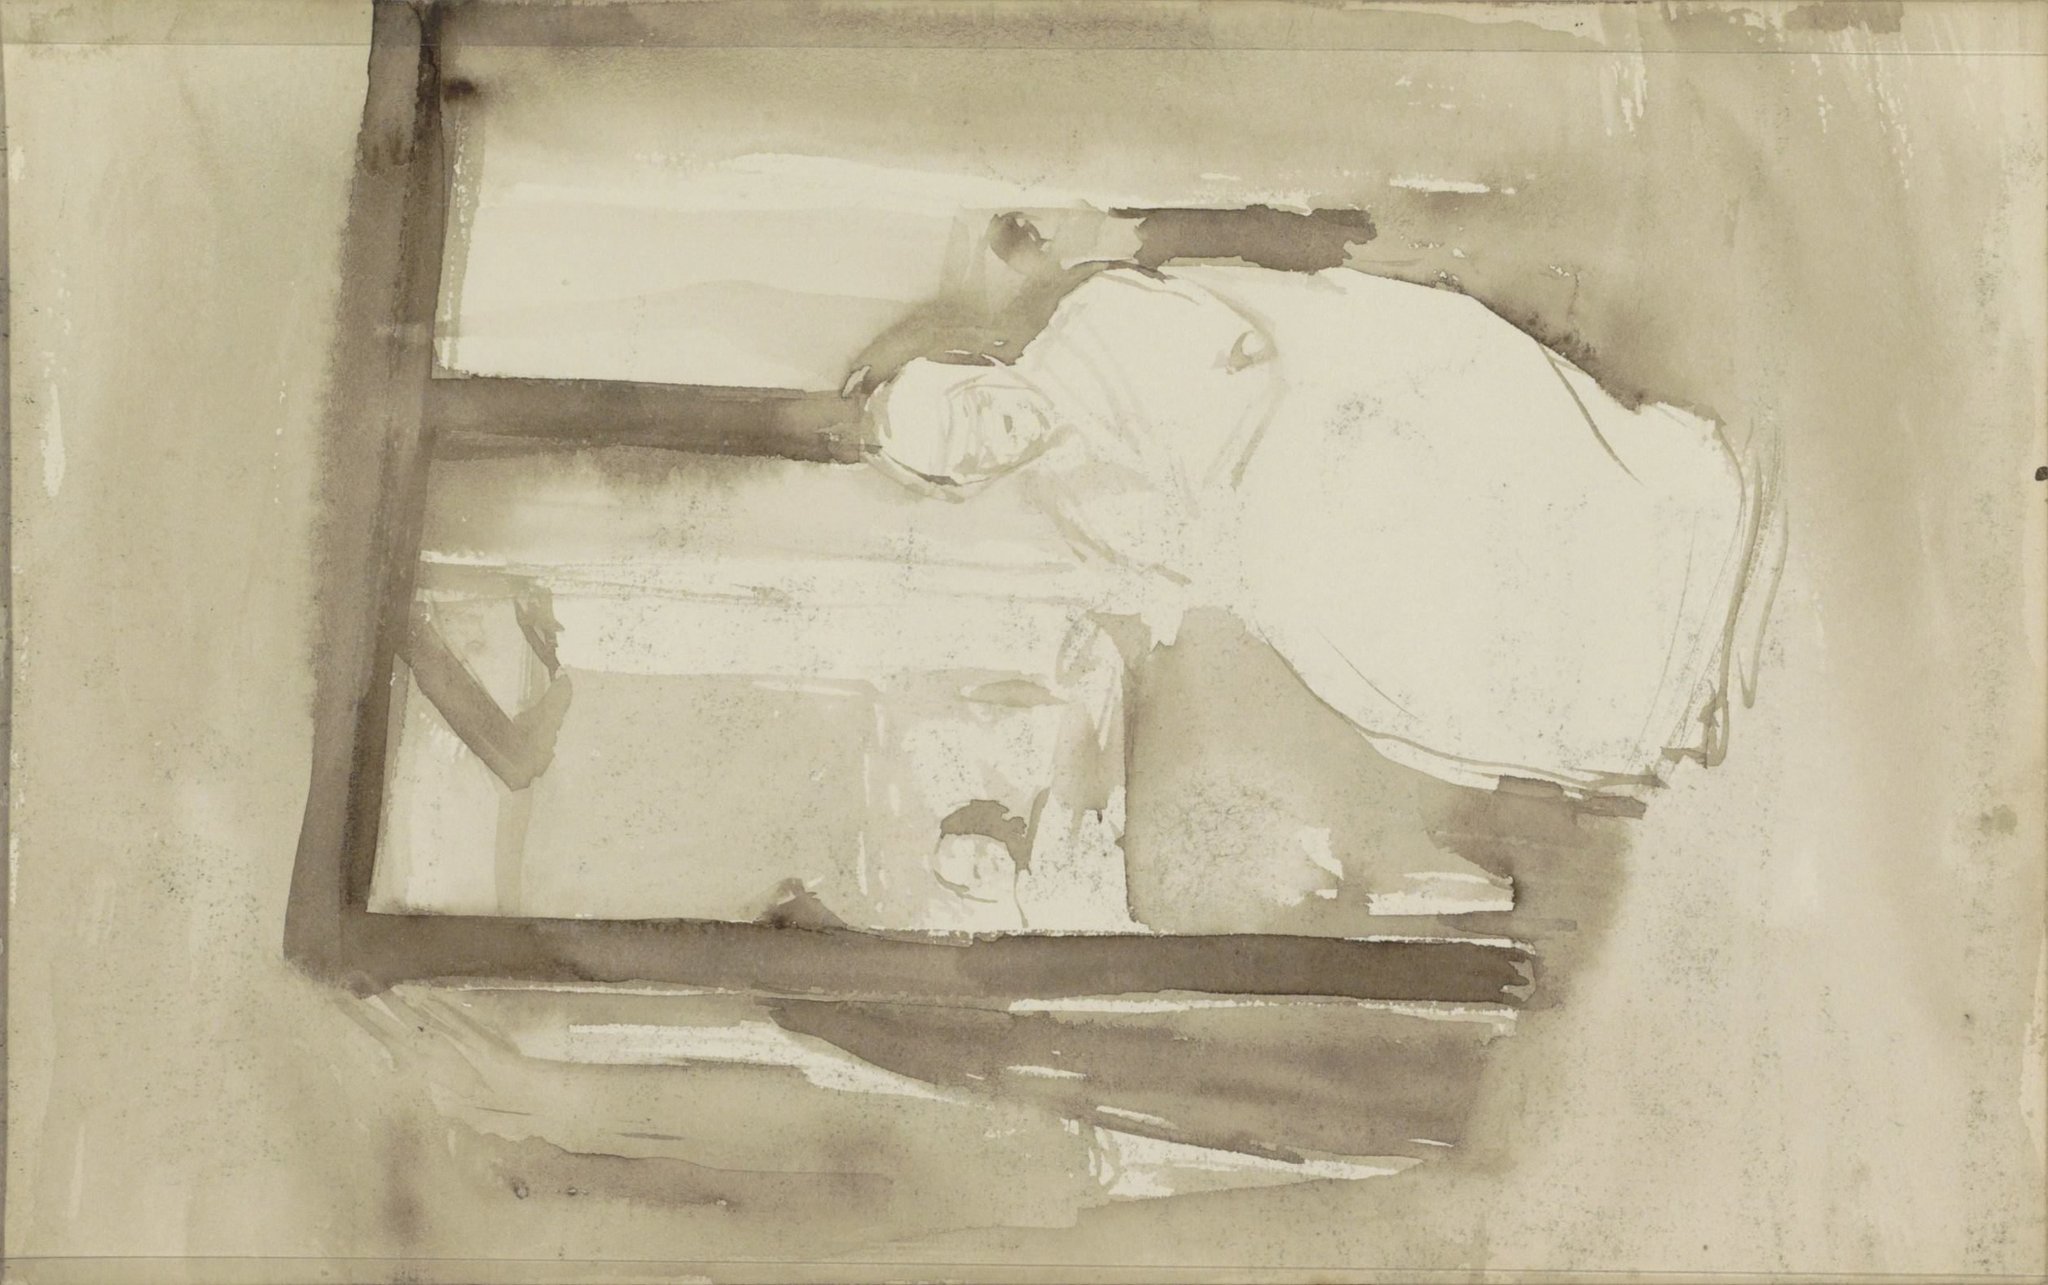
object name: sketchbook leaf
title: Handwerkende vrouw bij een serredeur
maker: a.a.l. de grammont-hubrecht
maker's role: draughtsman, painter, print maker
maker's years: 1855-1913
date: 1892-1913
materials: ink, paper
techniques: brush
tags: sitting figure, adult woman, door, home sewing; repair of clothes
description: Door het raam van de deur is een tweede figuur, vermoedelijk een zittende man, te zien. Blad 24 recto uit een schetsboek met 31 bladen.